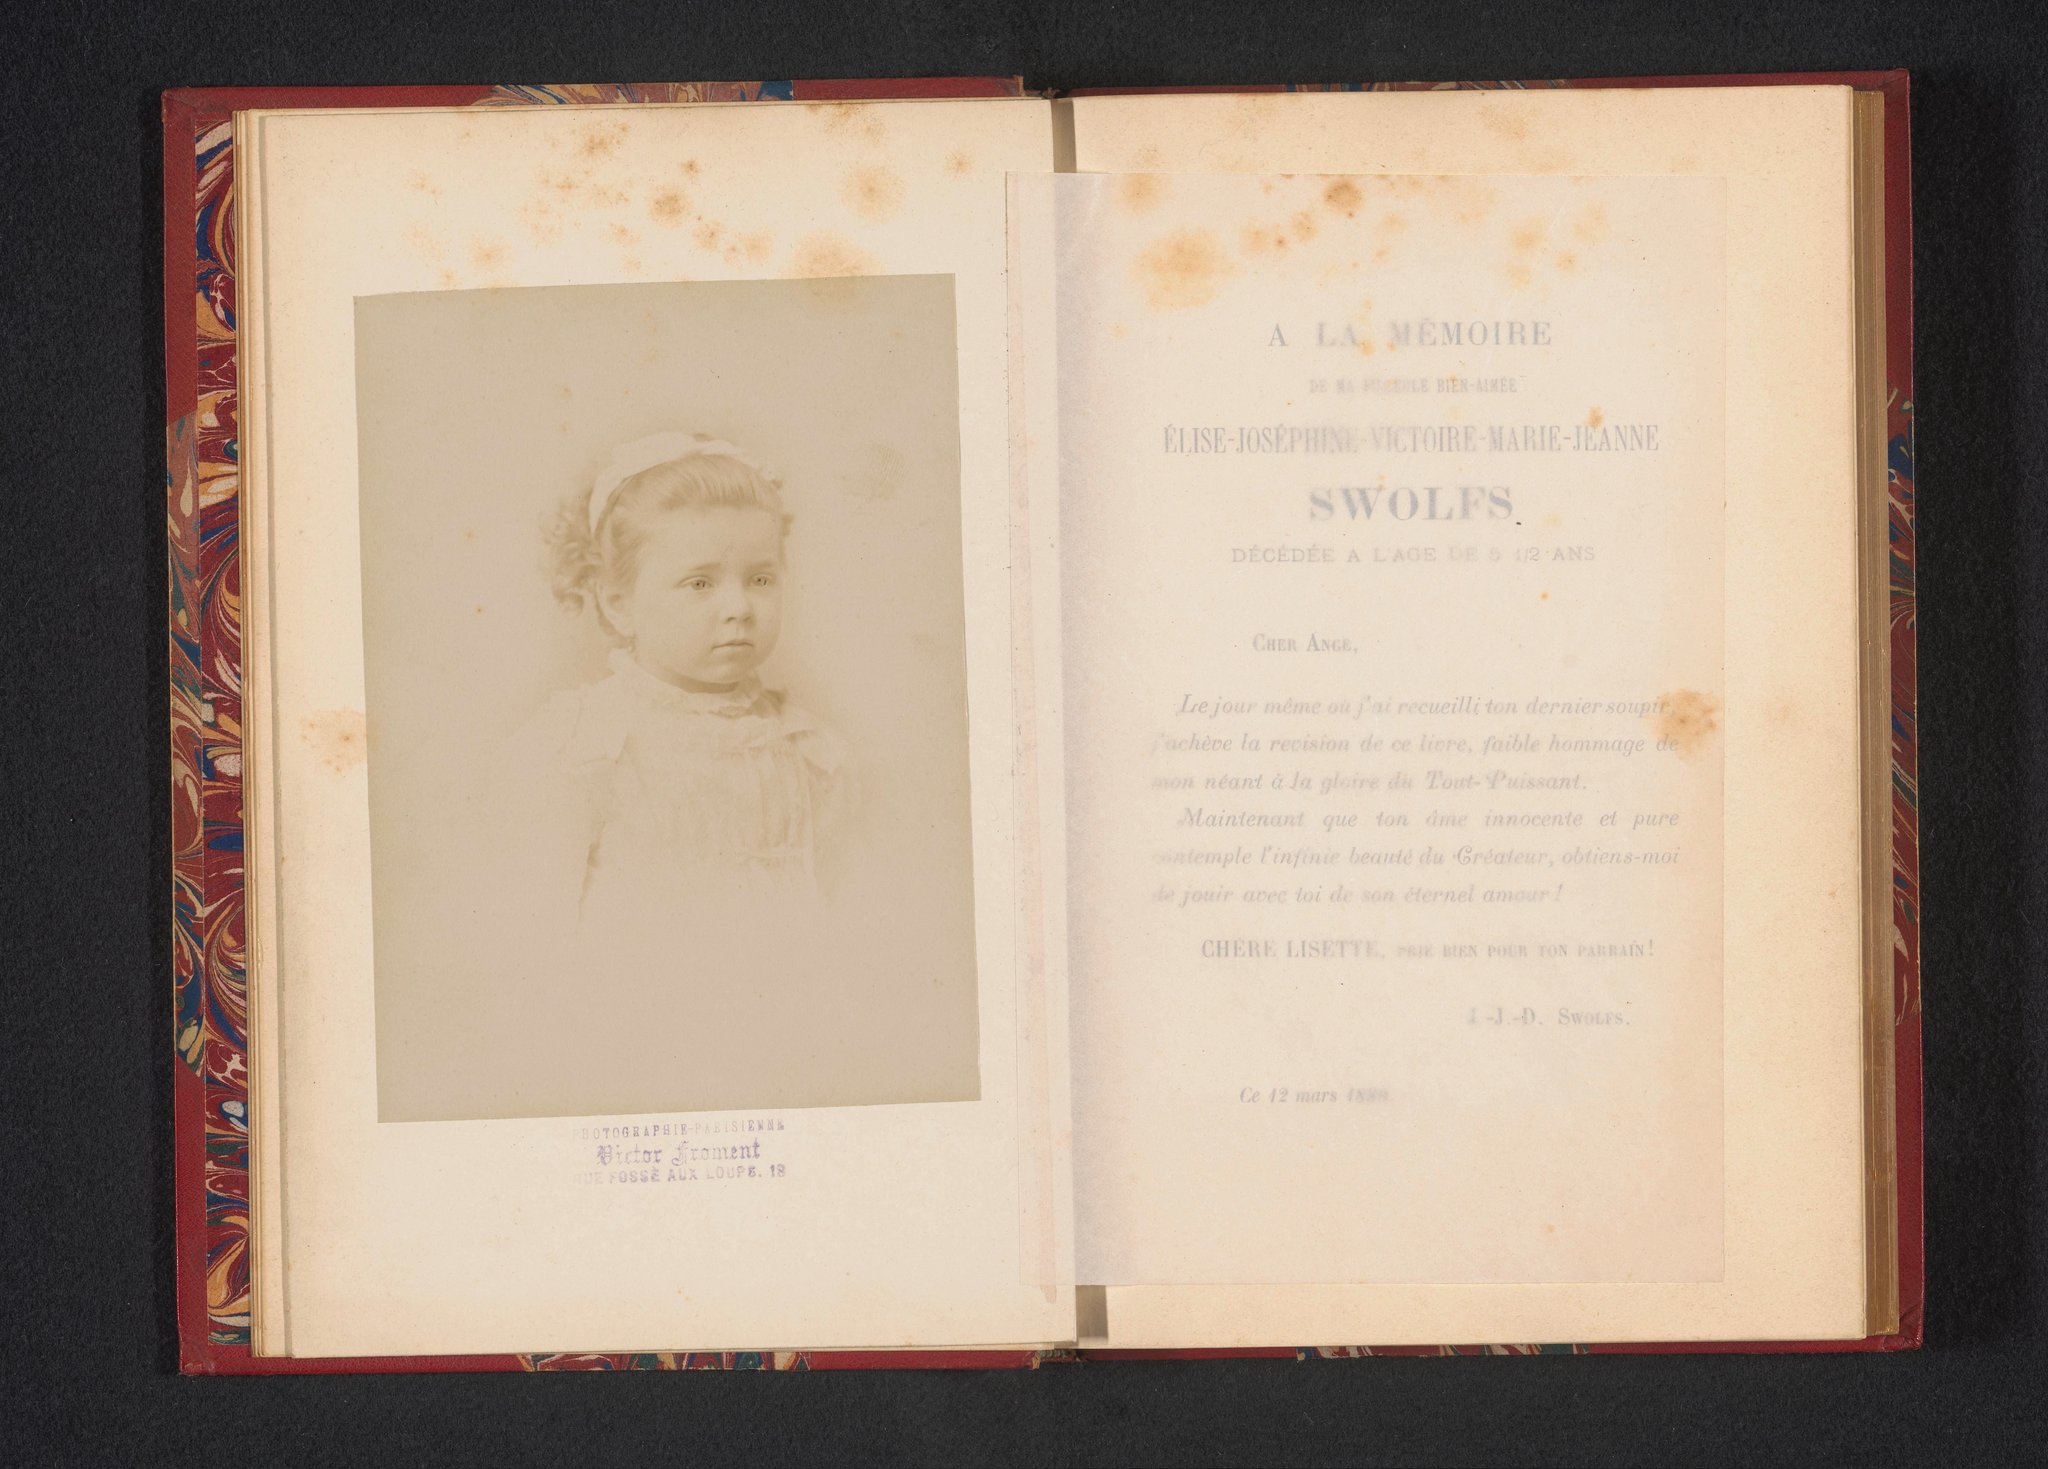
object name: page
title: Portret van Élise Joséphine Victoire Marie Jeanne Swolfs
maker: victor froment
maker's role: fotograaf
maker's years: 1842-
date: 1884-1889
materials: photographic support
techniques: albumen print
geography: brussels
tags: historical persons - bb - woman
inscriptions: address: ‘PHOTOGRAPHIE-PARISIENNE/ Victor Froment/ RUE FOSSE AUX LOUPE. 18’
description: Foto tegenover dedicatie, achter semi-transparante omslag.